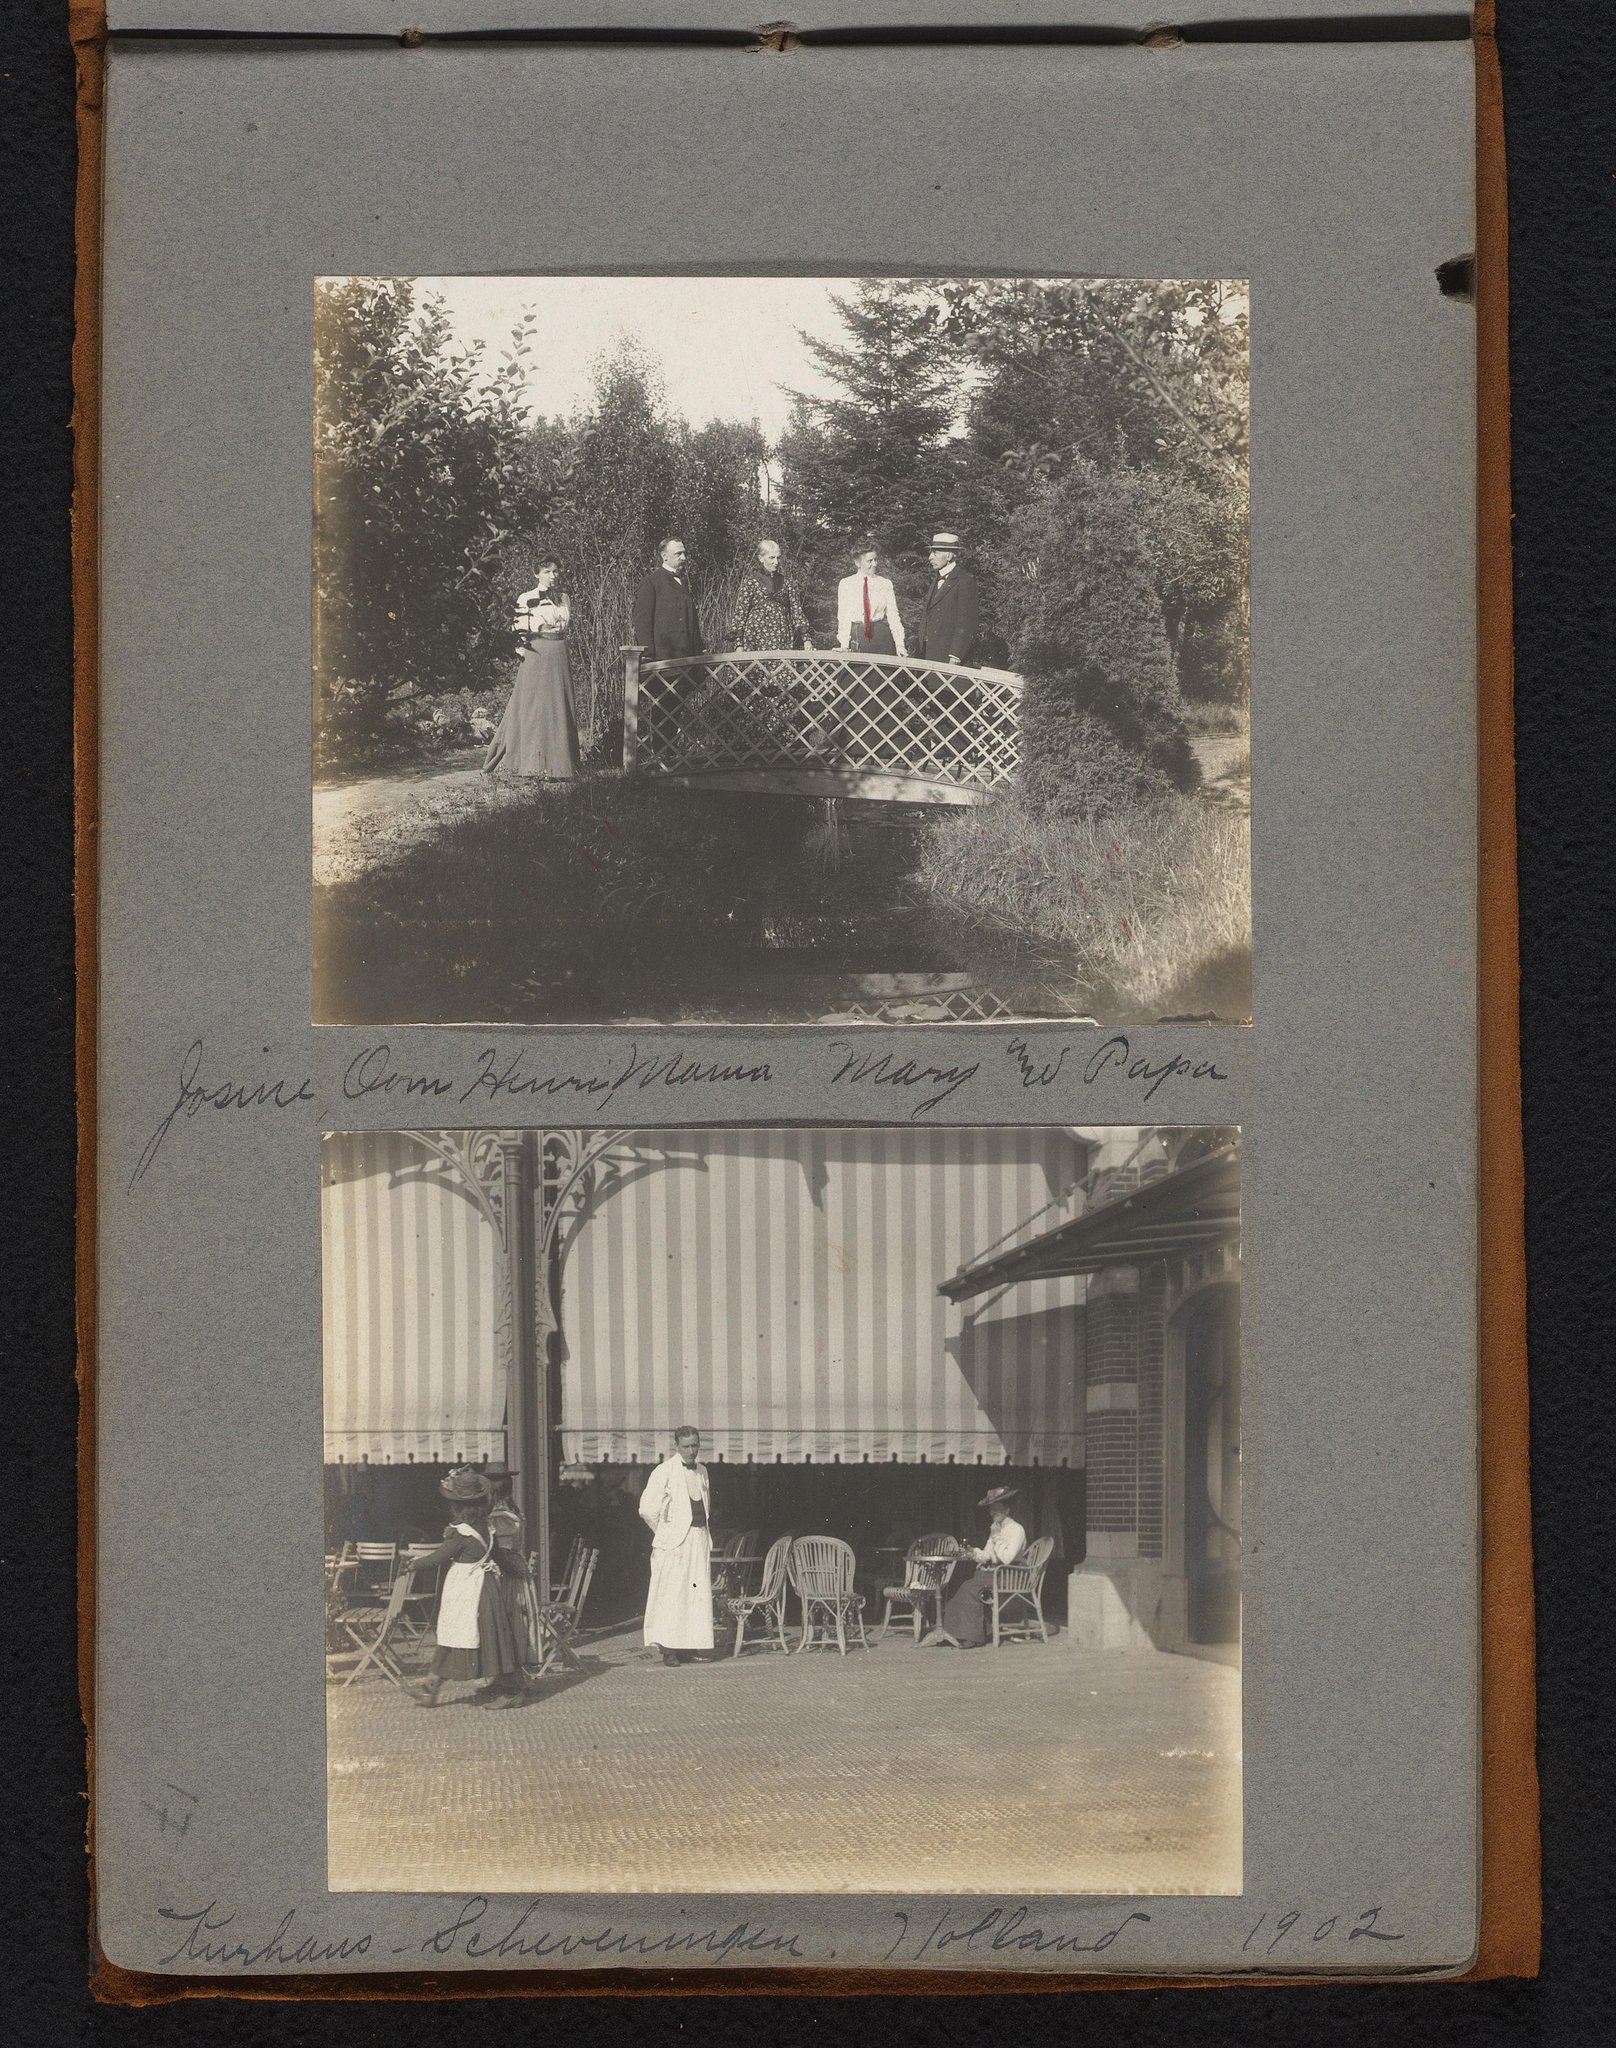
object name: photograph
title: Familieportret op een tuinbrug in Veghel en een terras voor het Kurhaus in Scheveningen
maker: jan van der mey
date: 1902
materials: paper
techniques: gelatin silver print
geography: netherlands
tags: mary van der mey, first degree family relationships, historical persons, pavement, terrace in front of inn or restaurant, bridge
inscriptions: inscription: ‘Josine, Oom Henri, Mama Mary and Papa/ Kurhaus, Scheveningen, Holland 1902’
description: Deze foto's maken deel uit van een album.